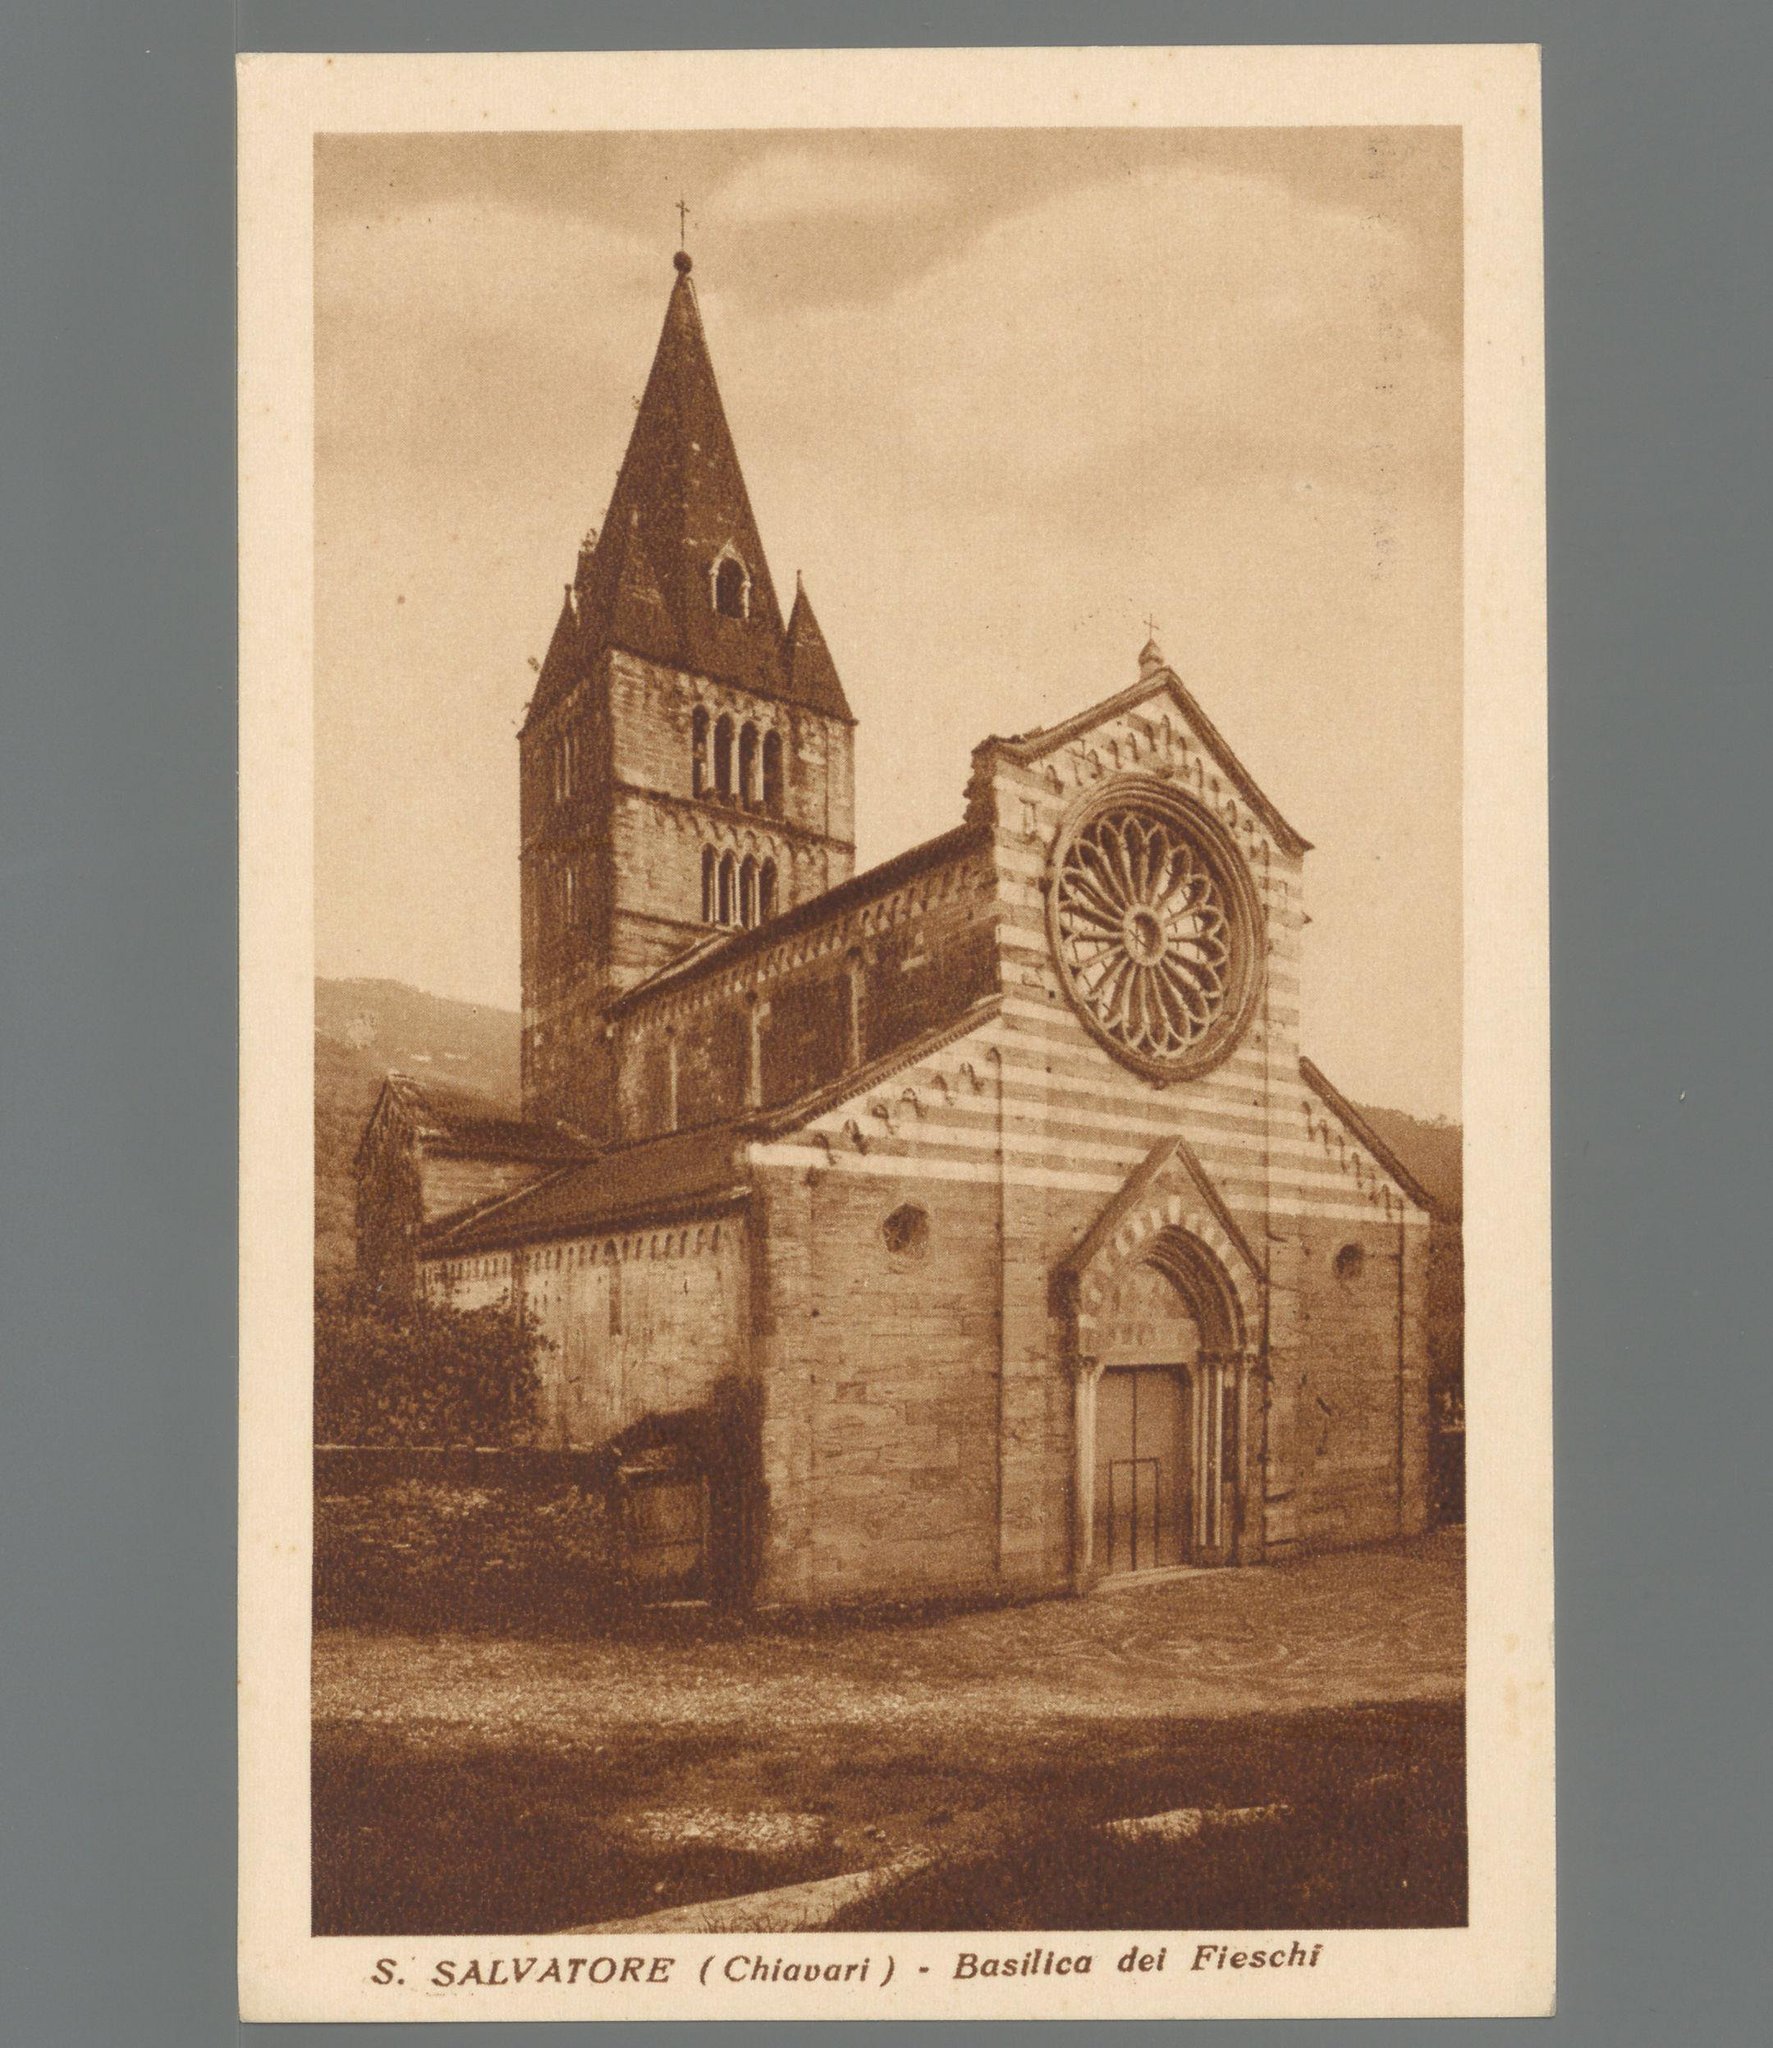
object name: ansichtkaart, prentbriefkaart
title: S. Salvatore (Chiavari). Basilica dei Fieschi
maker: c. piaggio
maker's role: publisher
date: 1906-1930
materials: cardboard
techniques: rotogravure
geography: chiavari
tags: church (exterior)